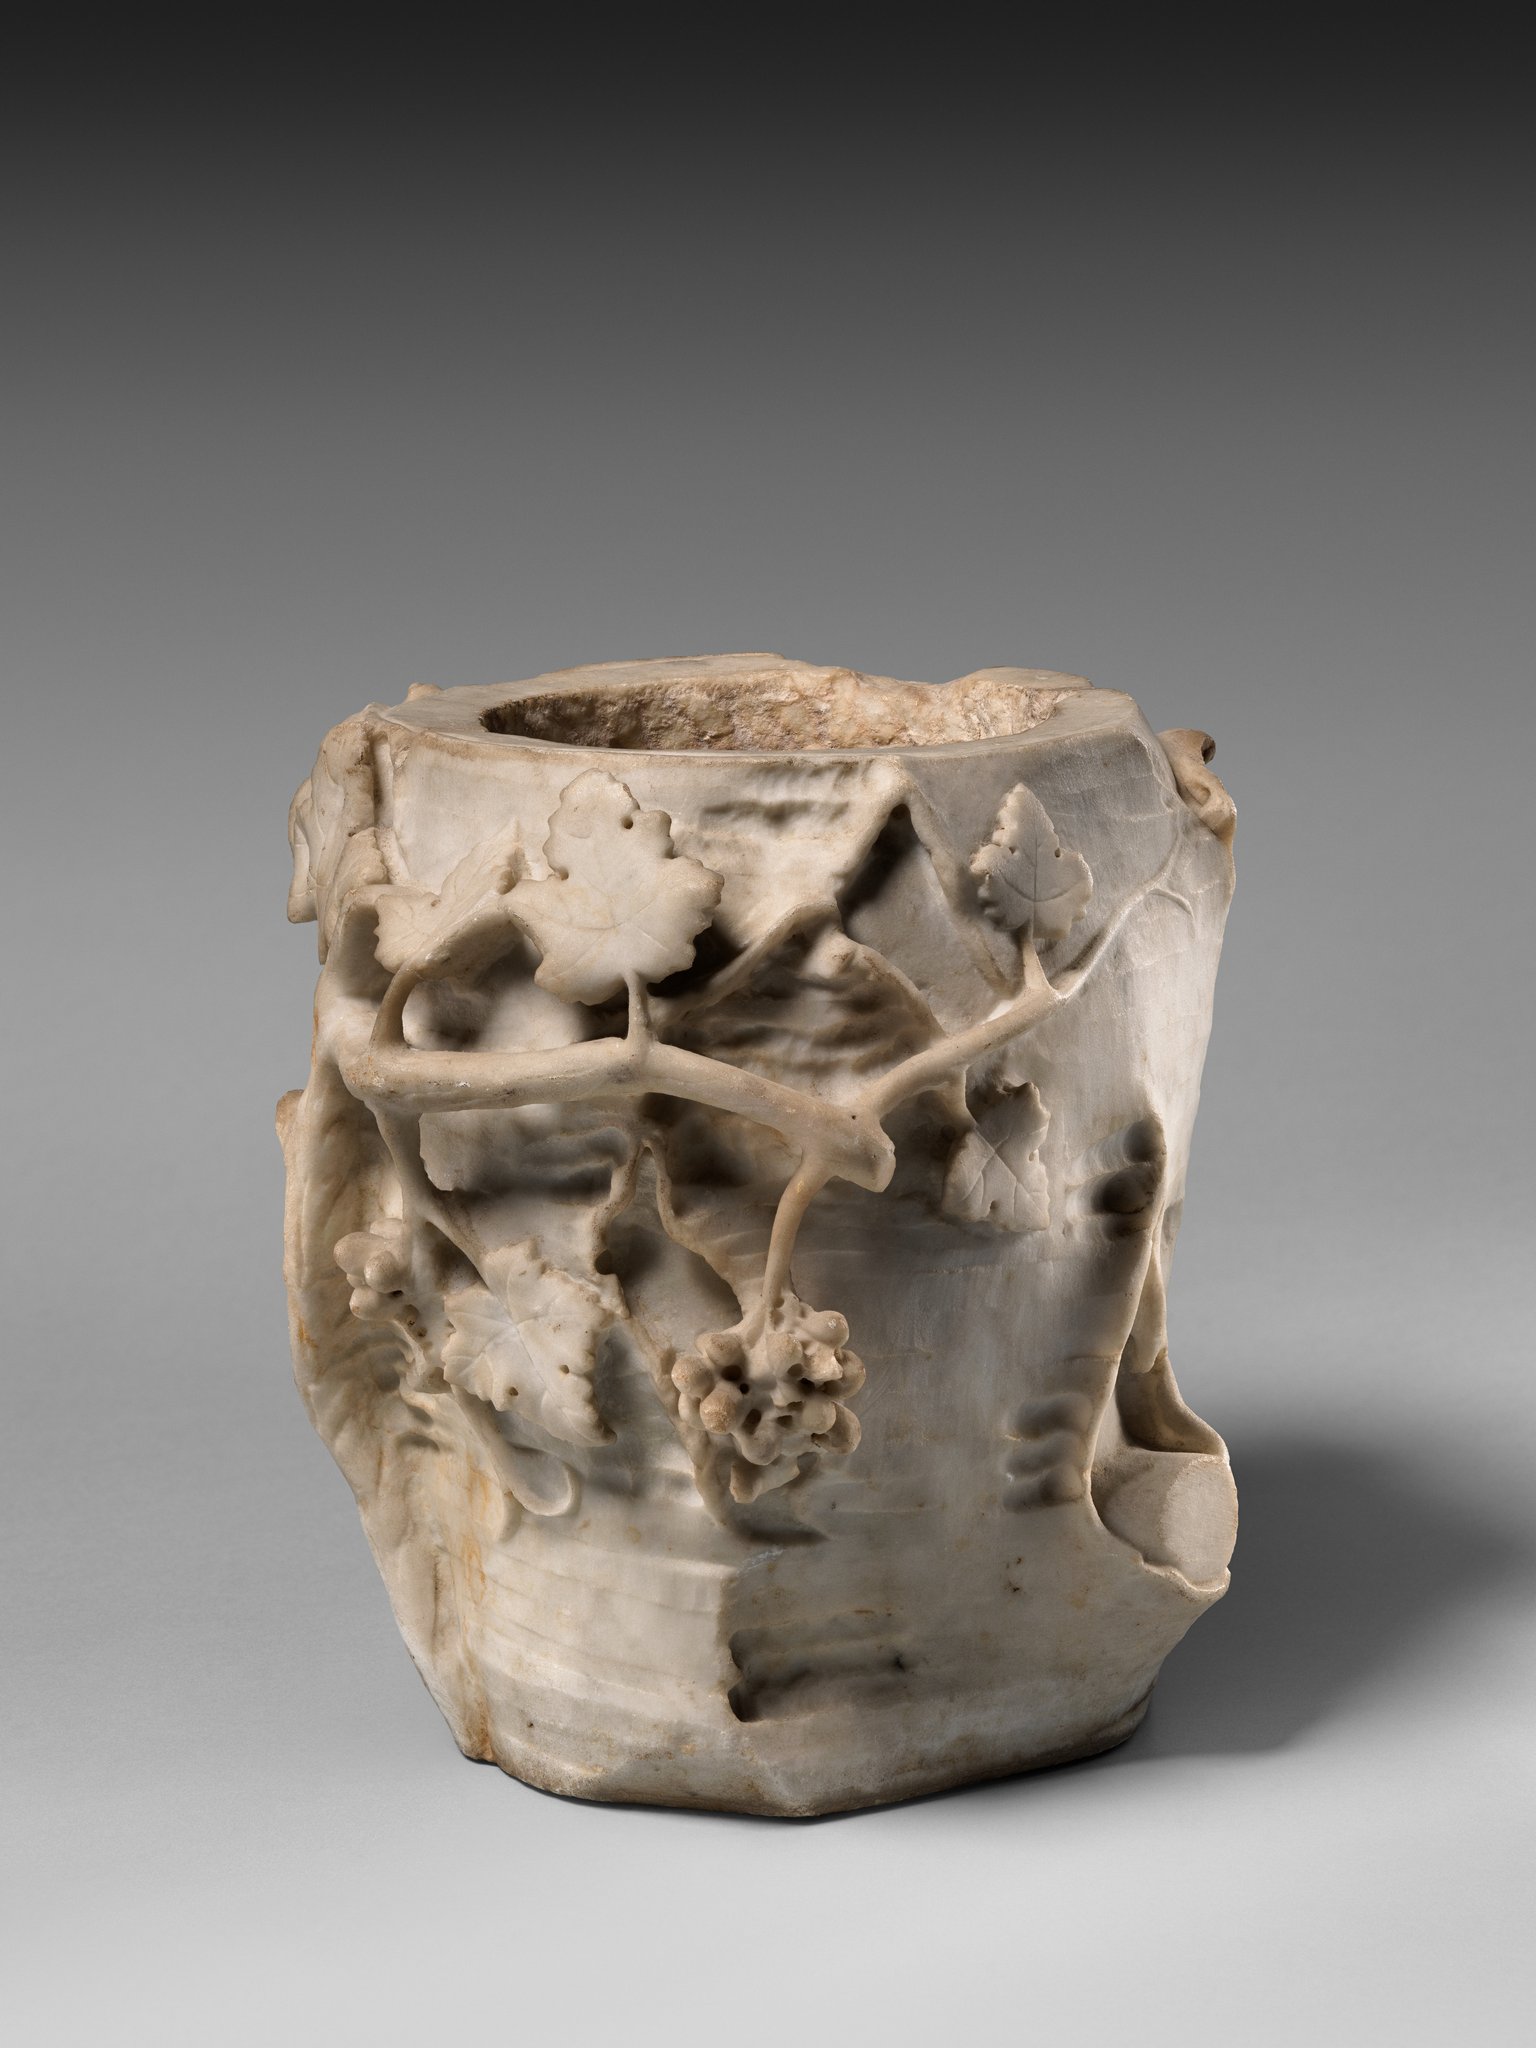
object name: urn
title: Marble cinerary urn in the form of a tree stump with leaves and grapes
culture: roman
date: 1-100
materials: marble